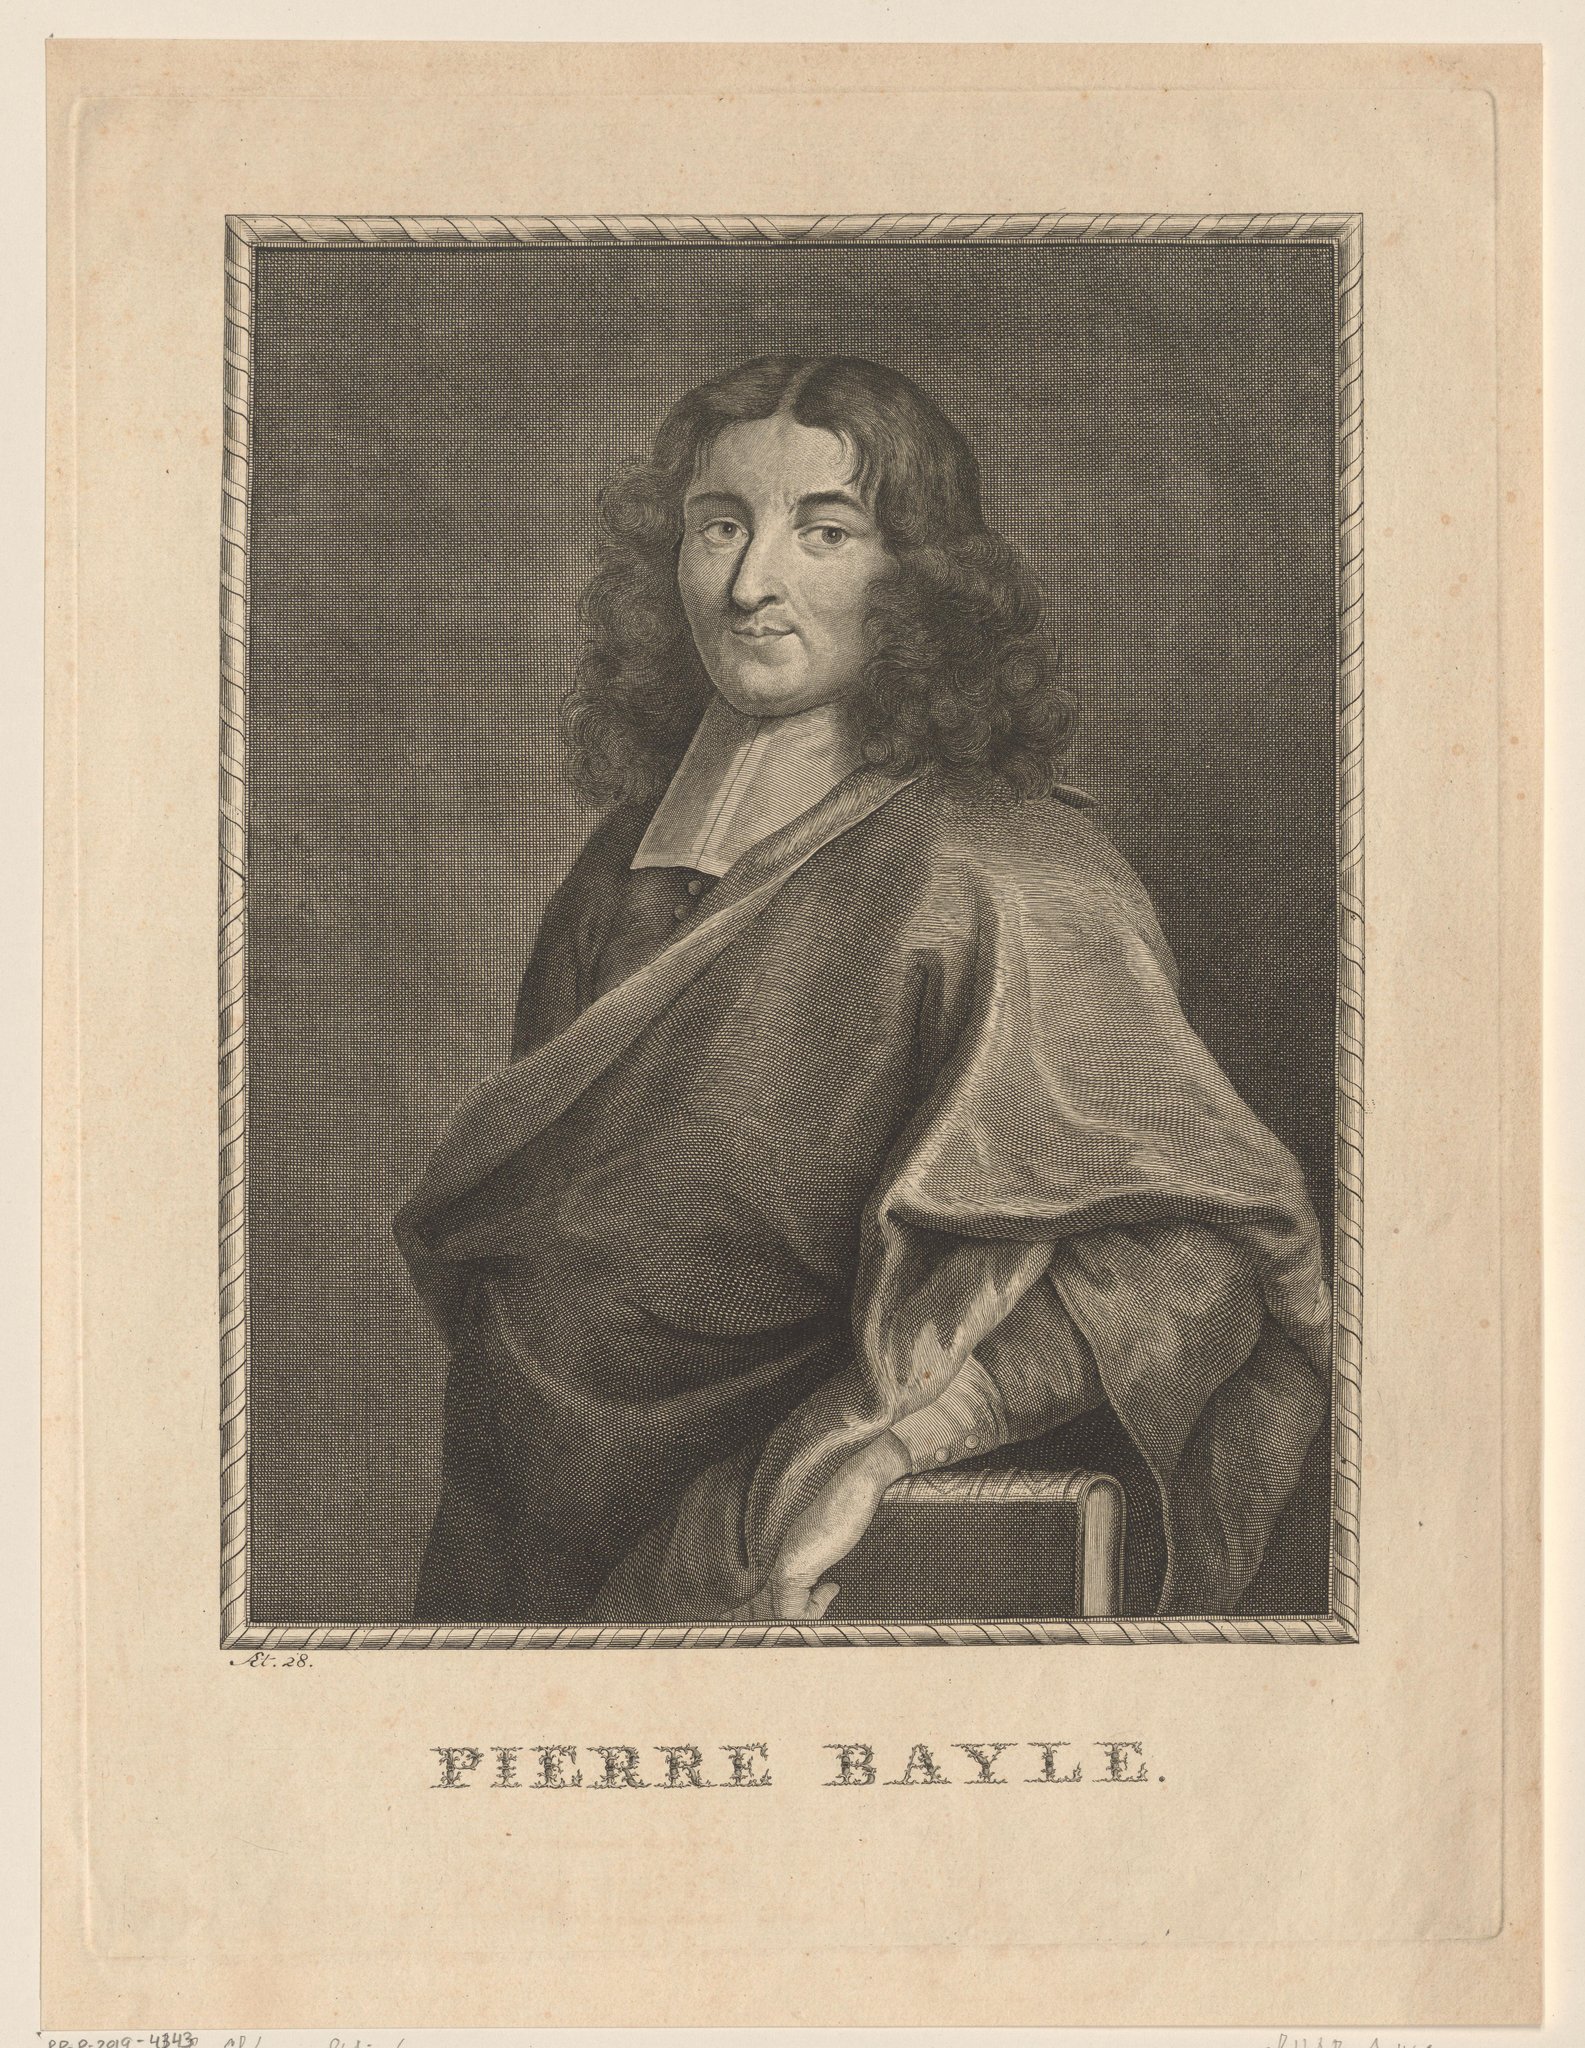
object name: print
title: Portret van Pierre Bayle op 28-jarige leeftijd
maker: Anonymous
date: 1675-1749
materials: paper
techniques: engraving, etching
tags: rotterdam, historical persons, book